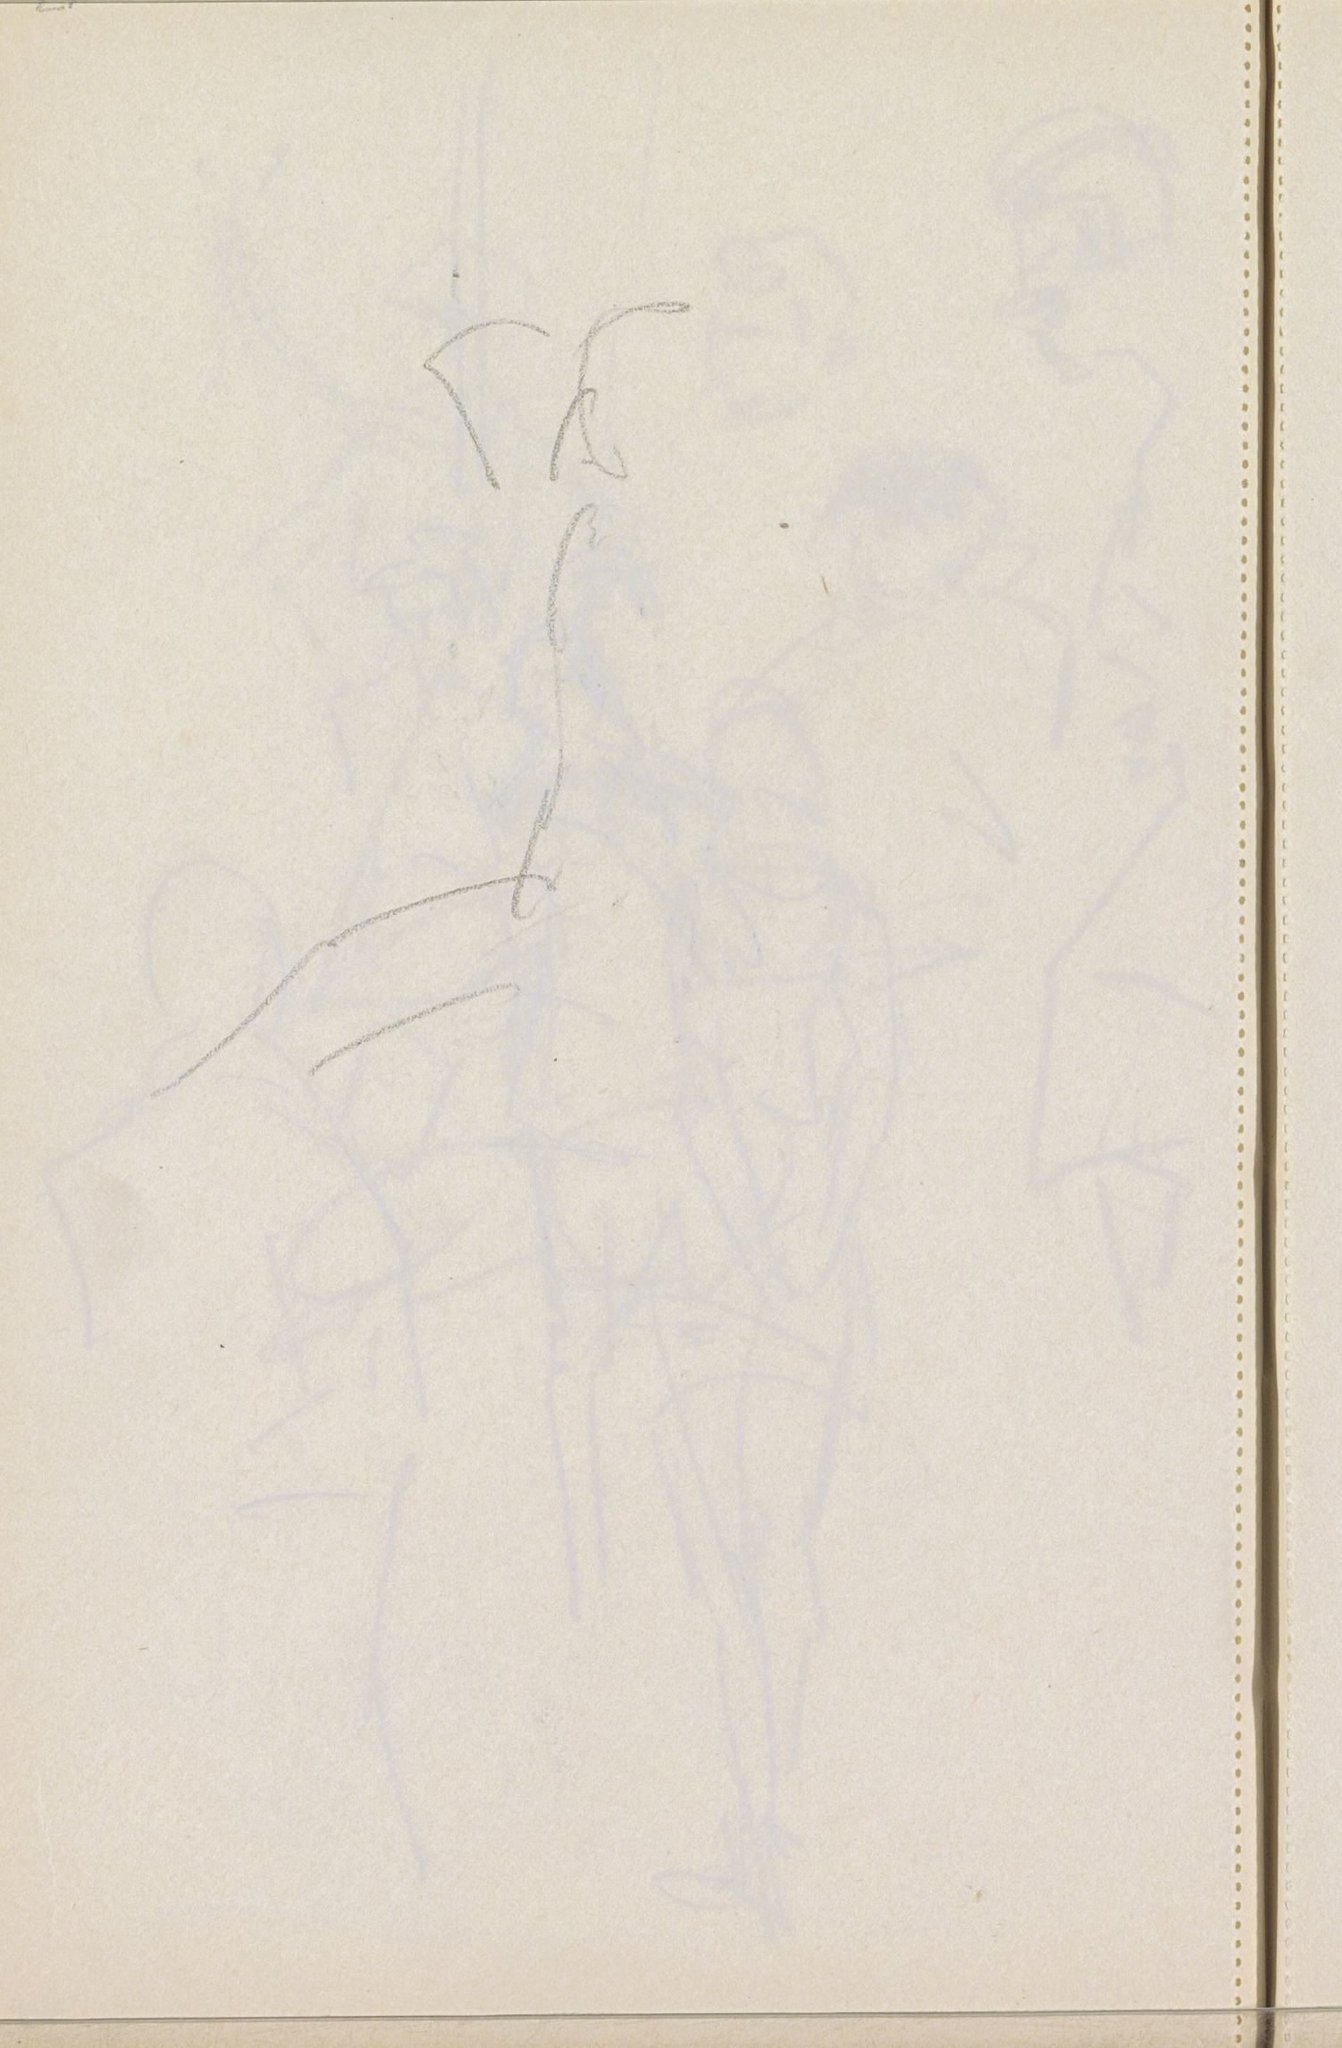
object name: sketchbook leaf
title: Figuurstudie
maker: isaac israels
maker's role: draughtsman, painter, print maker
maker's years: 1865-1934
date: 1875-1934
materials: paper, pencil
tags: the (nude) human figure; 'corpo humano' (ripa)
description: Blad 31 verso uit schetsboek LII met 43 bladen.